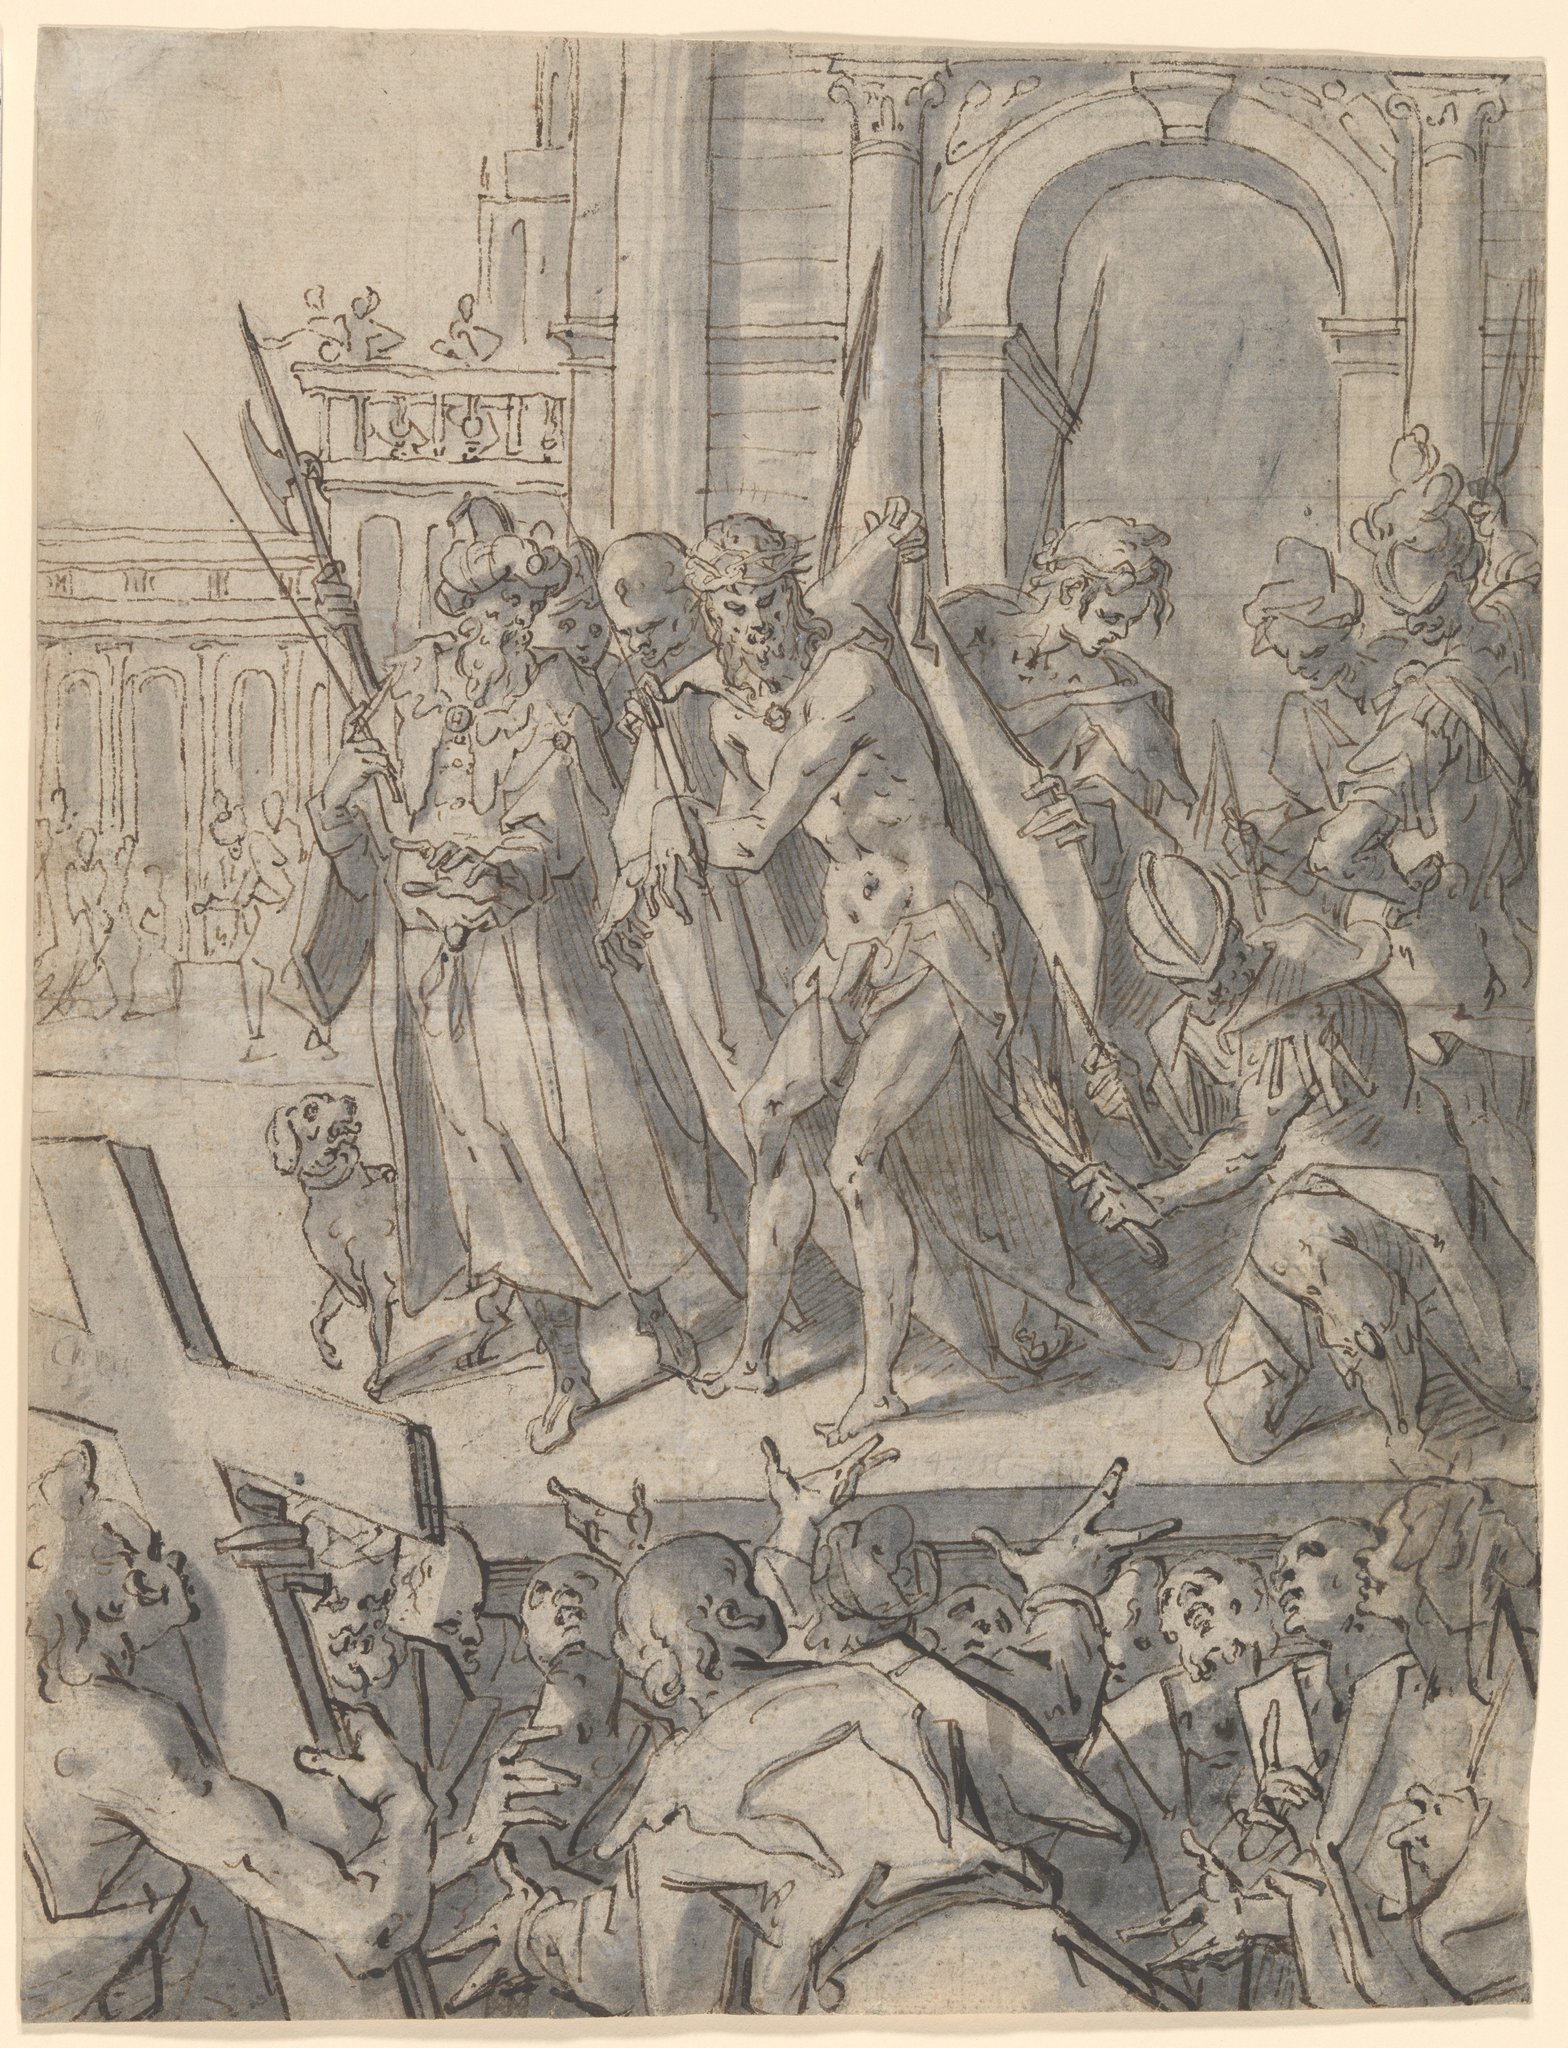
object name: drawing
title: Ecce Homo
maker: hans von aachen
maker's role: artist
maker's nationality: german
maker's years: 1552-1616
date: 1590-1600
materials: chalk, ink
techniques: brush, pen, wash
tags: weapons,men,cross